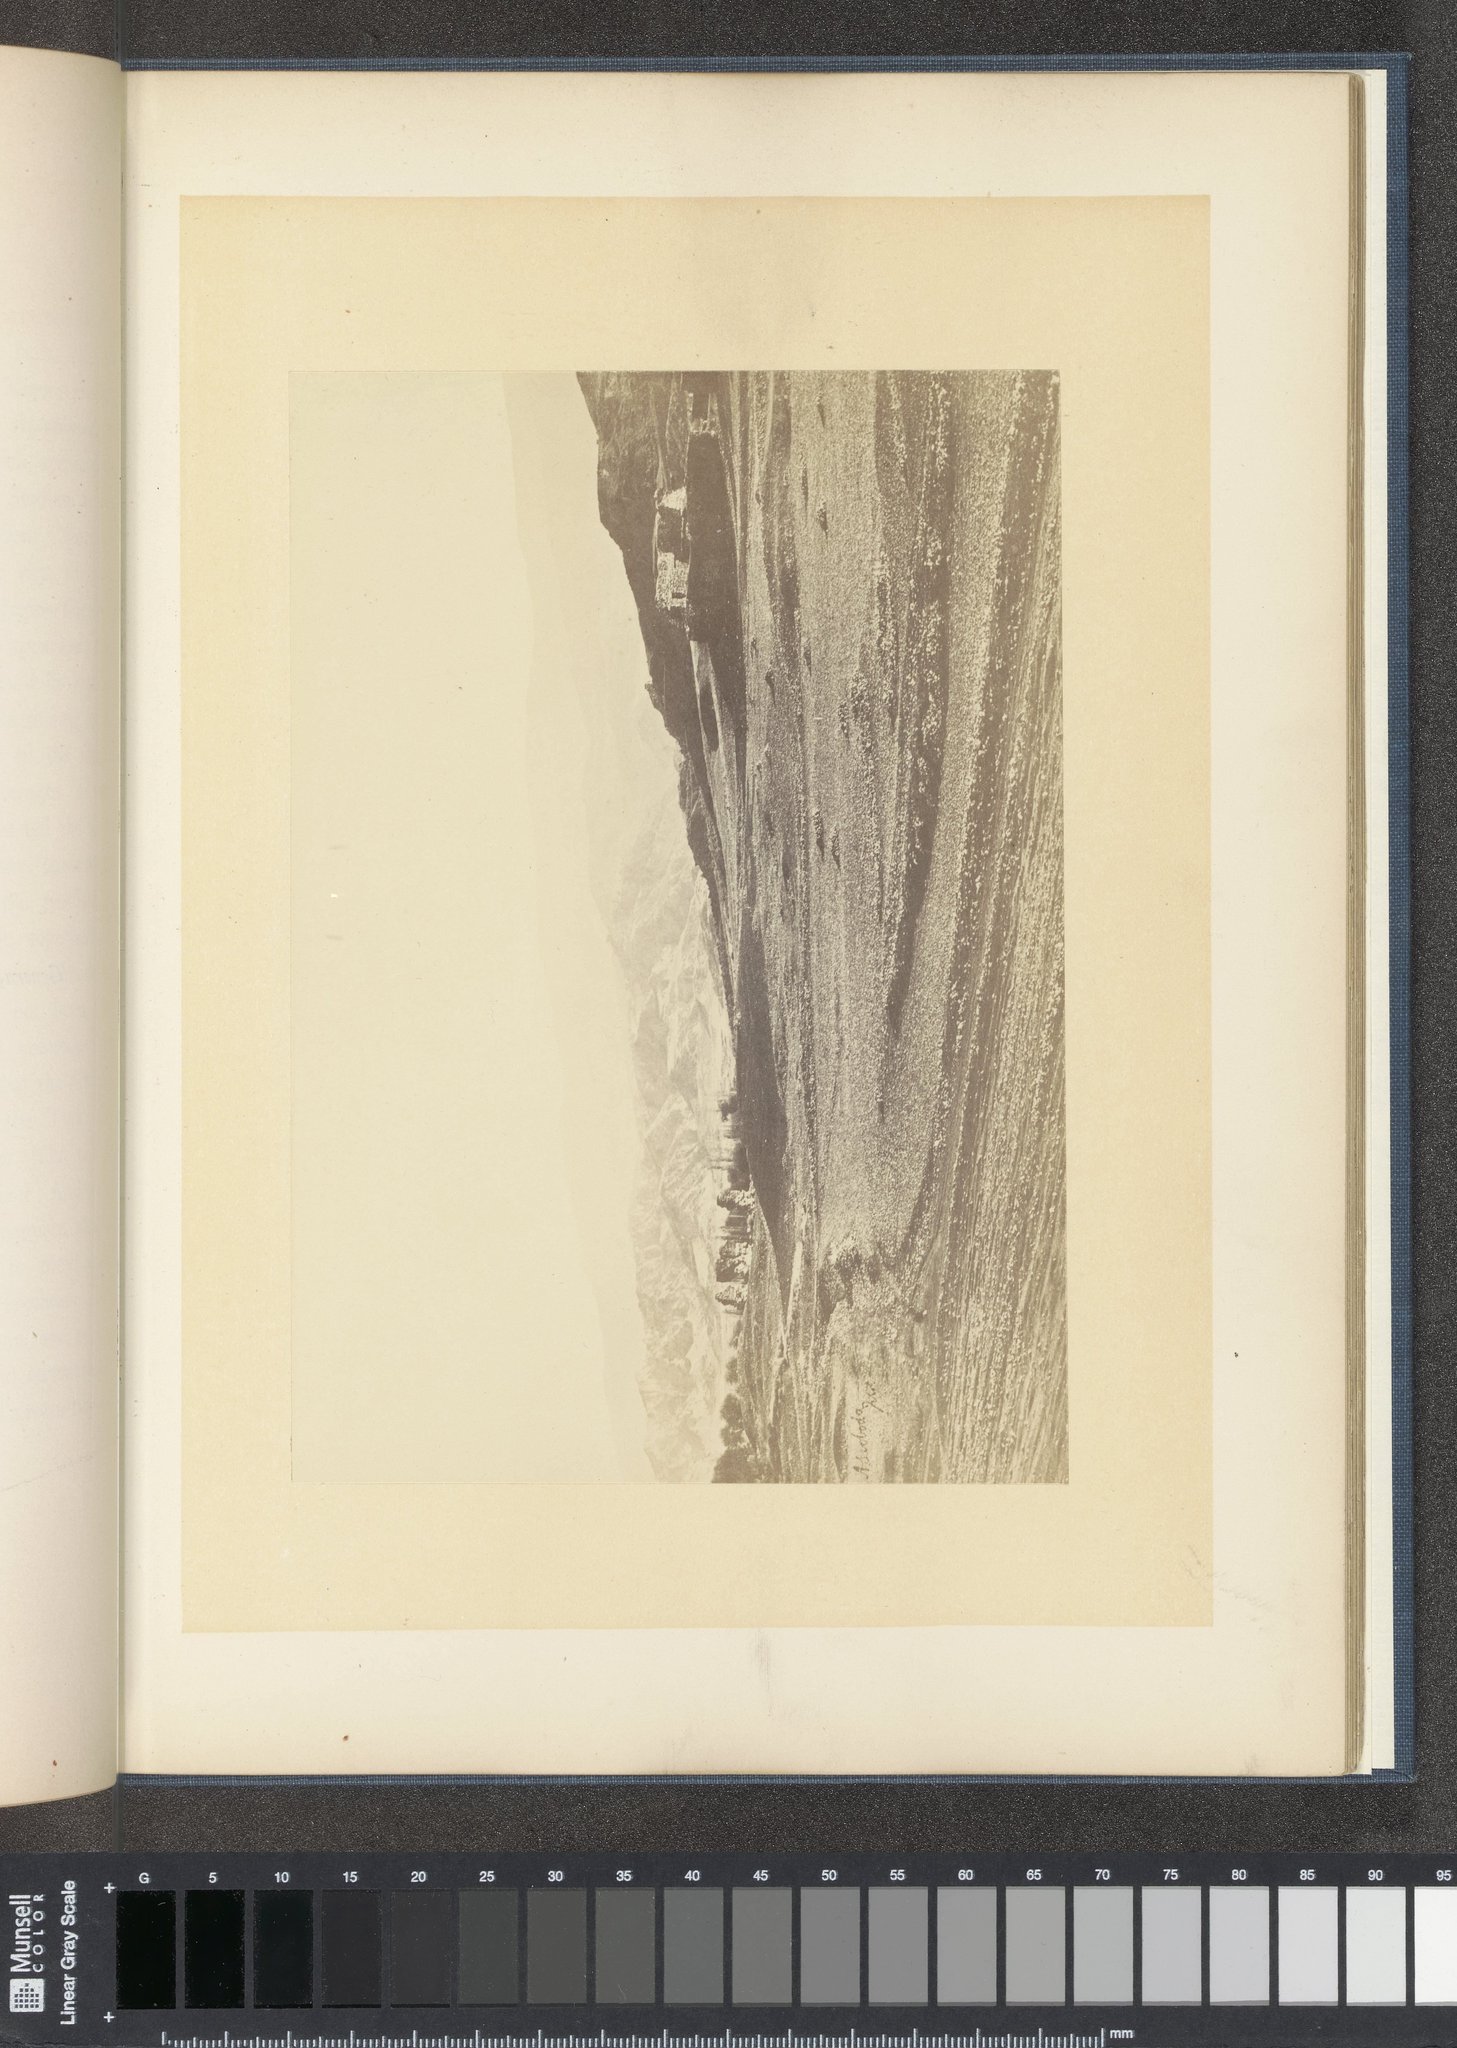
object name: photograph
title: Gezicht op ruïnes te Sardis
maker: alexander svoboda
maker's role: fotograaf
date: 1859-1869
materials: photographic support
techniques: albumen print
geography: asia minor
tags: ruin of a building ~ architecture